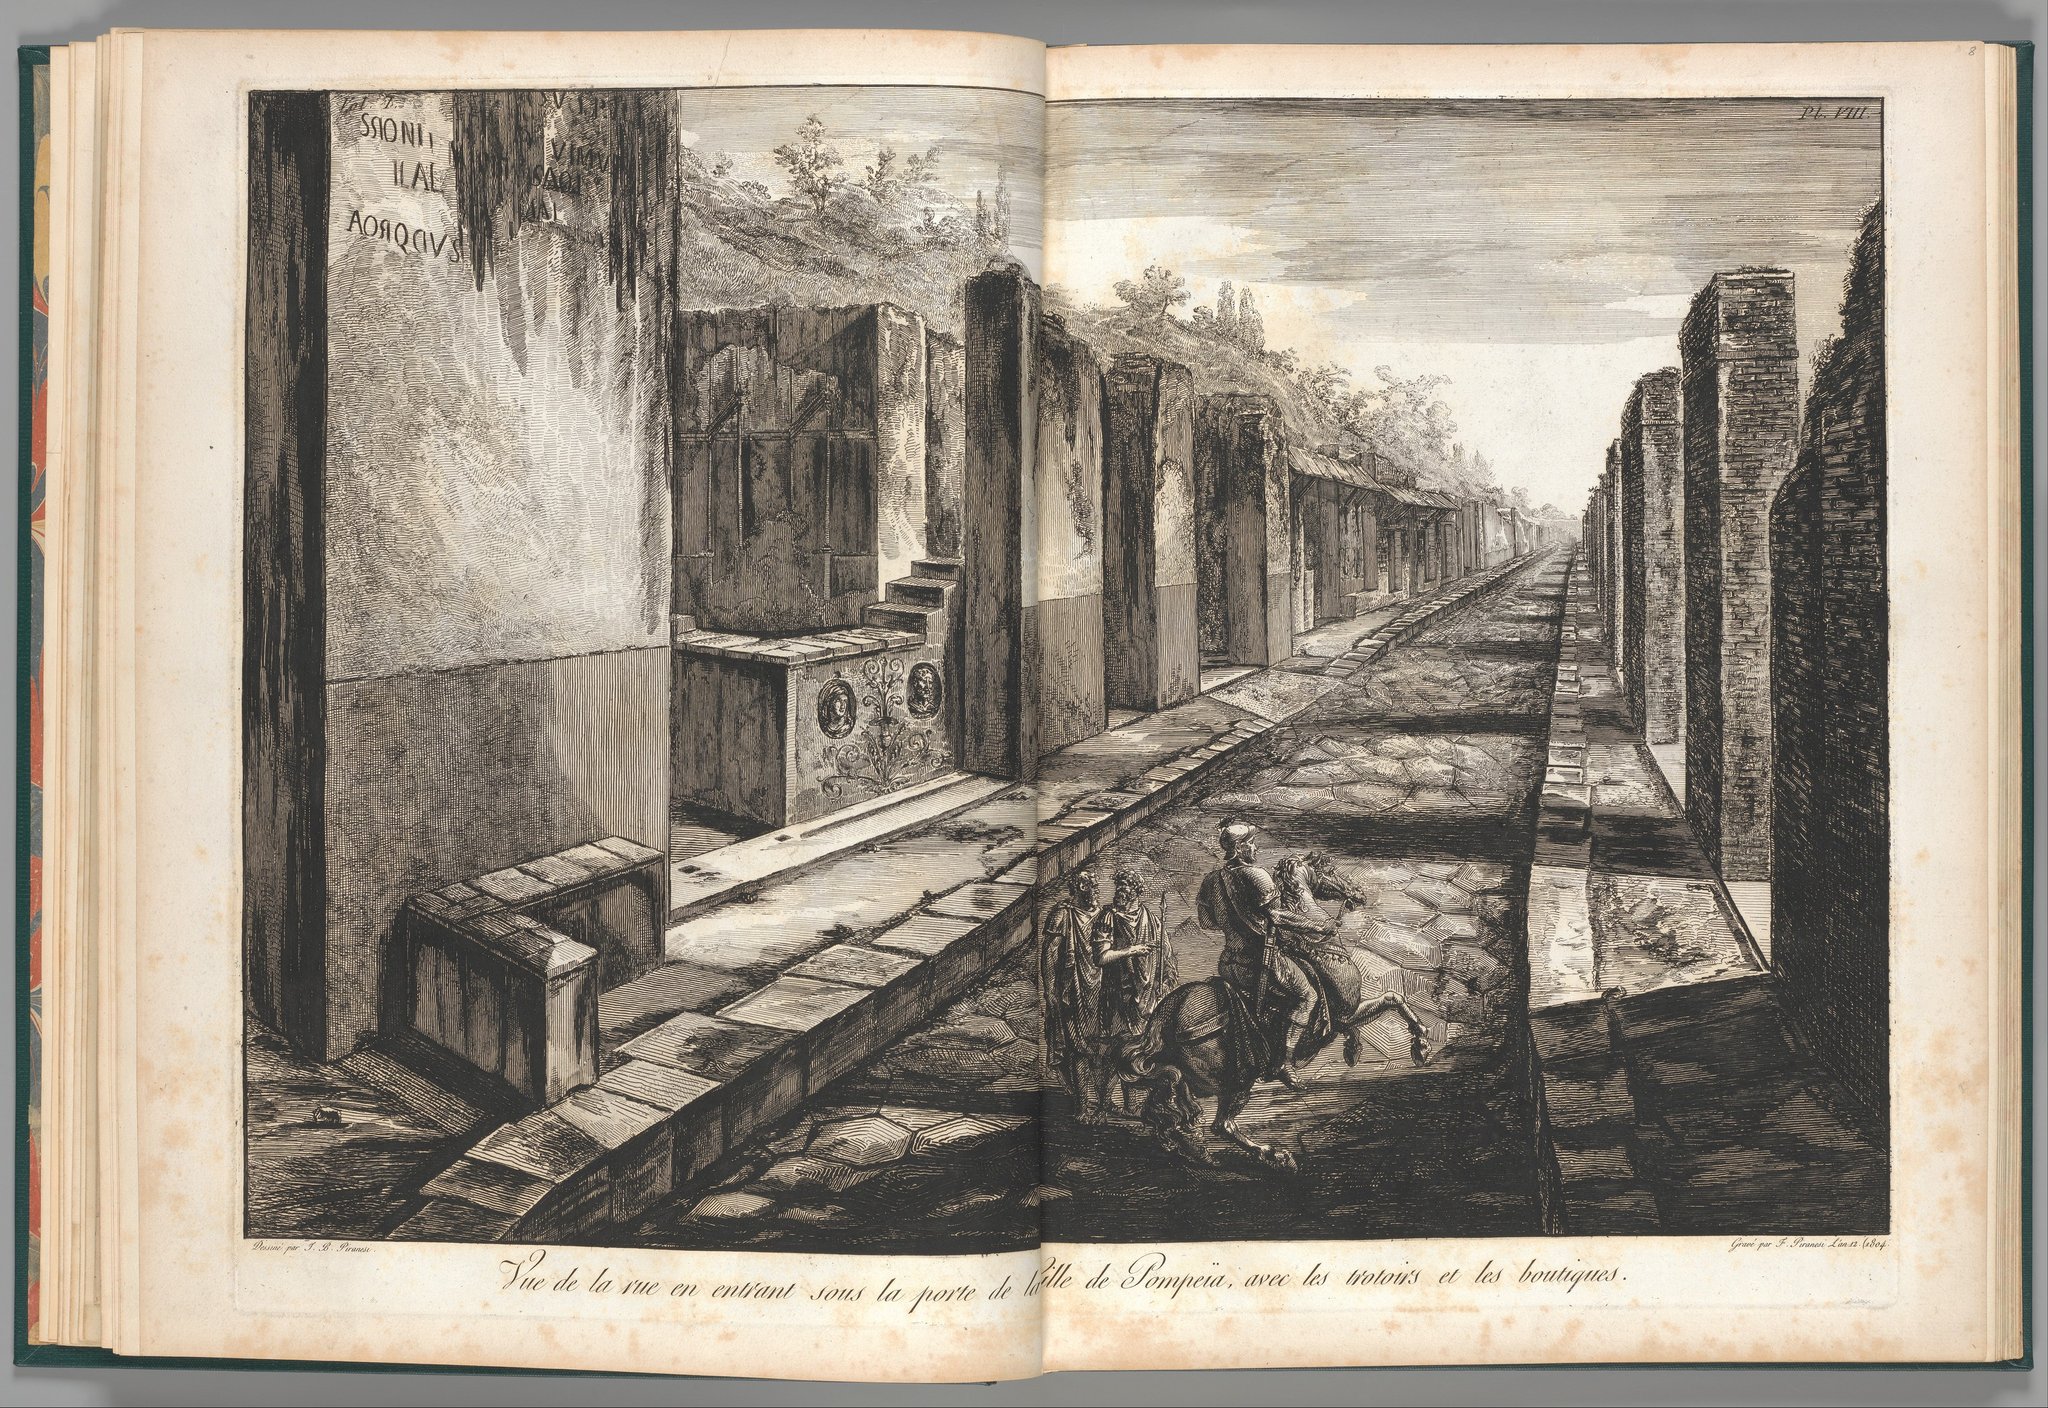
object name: print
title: View from the street entering beneath the gateway to the city of Pompeii, with the foot paths and the shops, from "Antiquités de Pompeïa, tome premier, Antiquités de la Grande Grèce..." (Antiquities of Pompeii, volume one, Antiquities of Great Greece...), volume 1, plate 8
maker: francesco piranesi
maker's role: artist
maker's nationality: italian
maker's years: 1758-1810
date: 1804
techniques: etching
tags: streets,men,horses